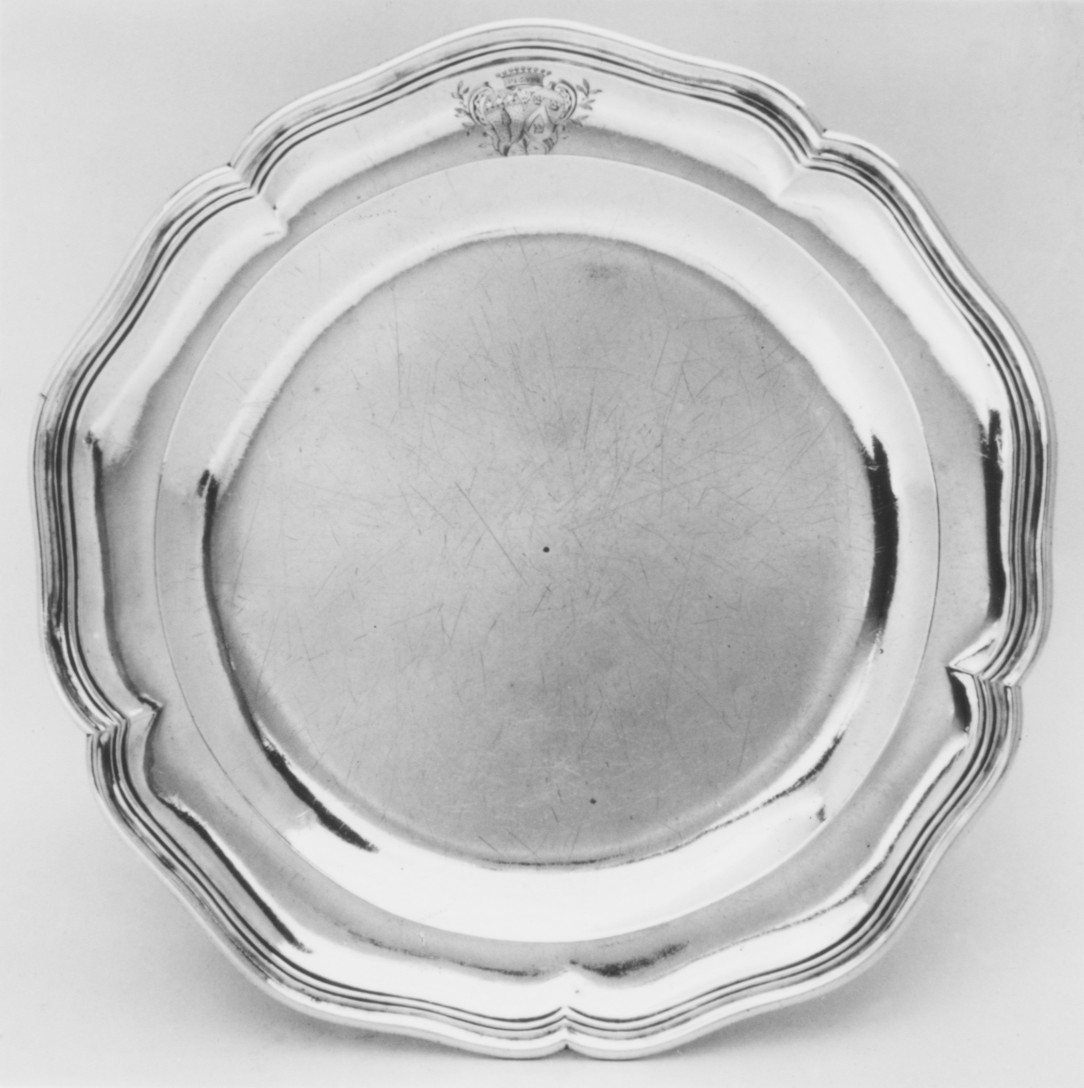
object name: plate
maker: jean chaslon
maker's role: maker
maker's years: 1733-1792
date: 1765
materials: silver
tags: coat of arms